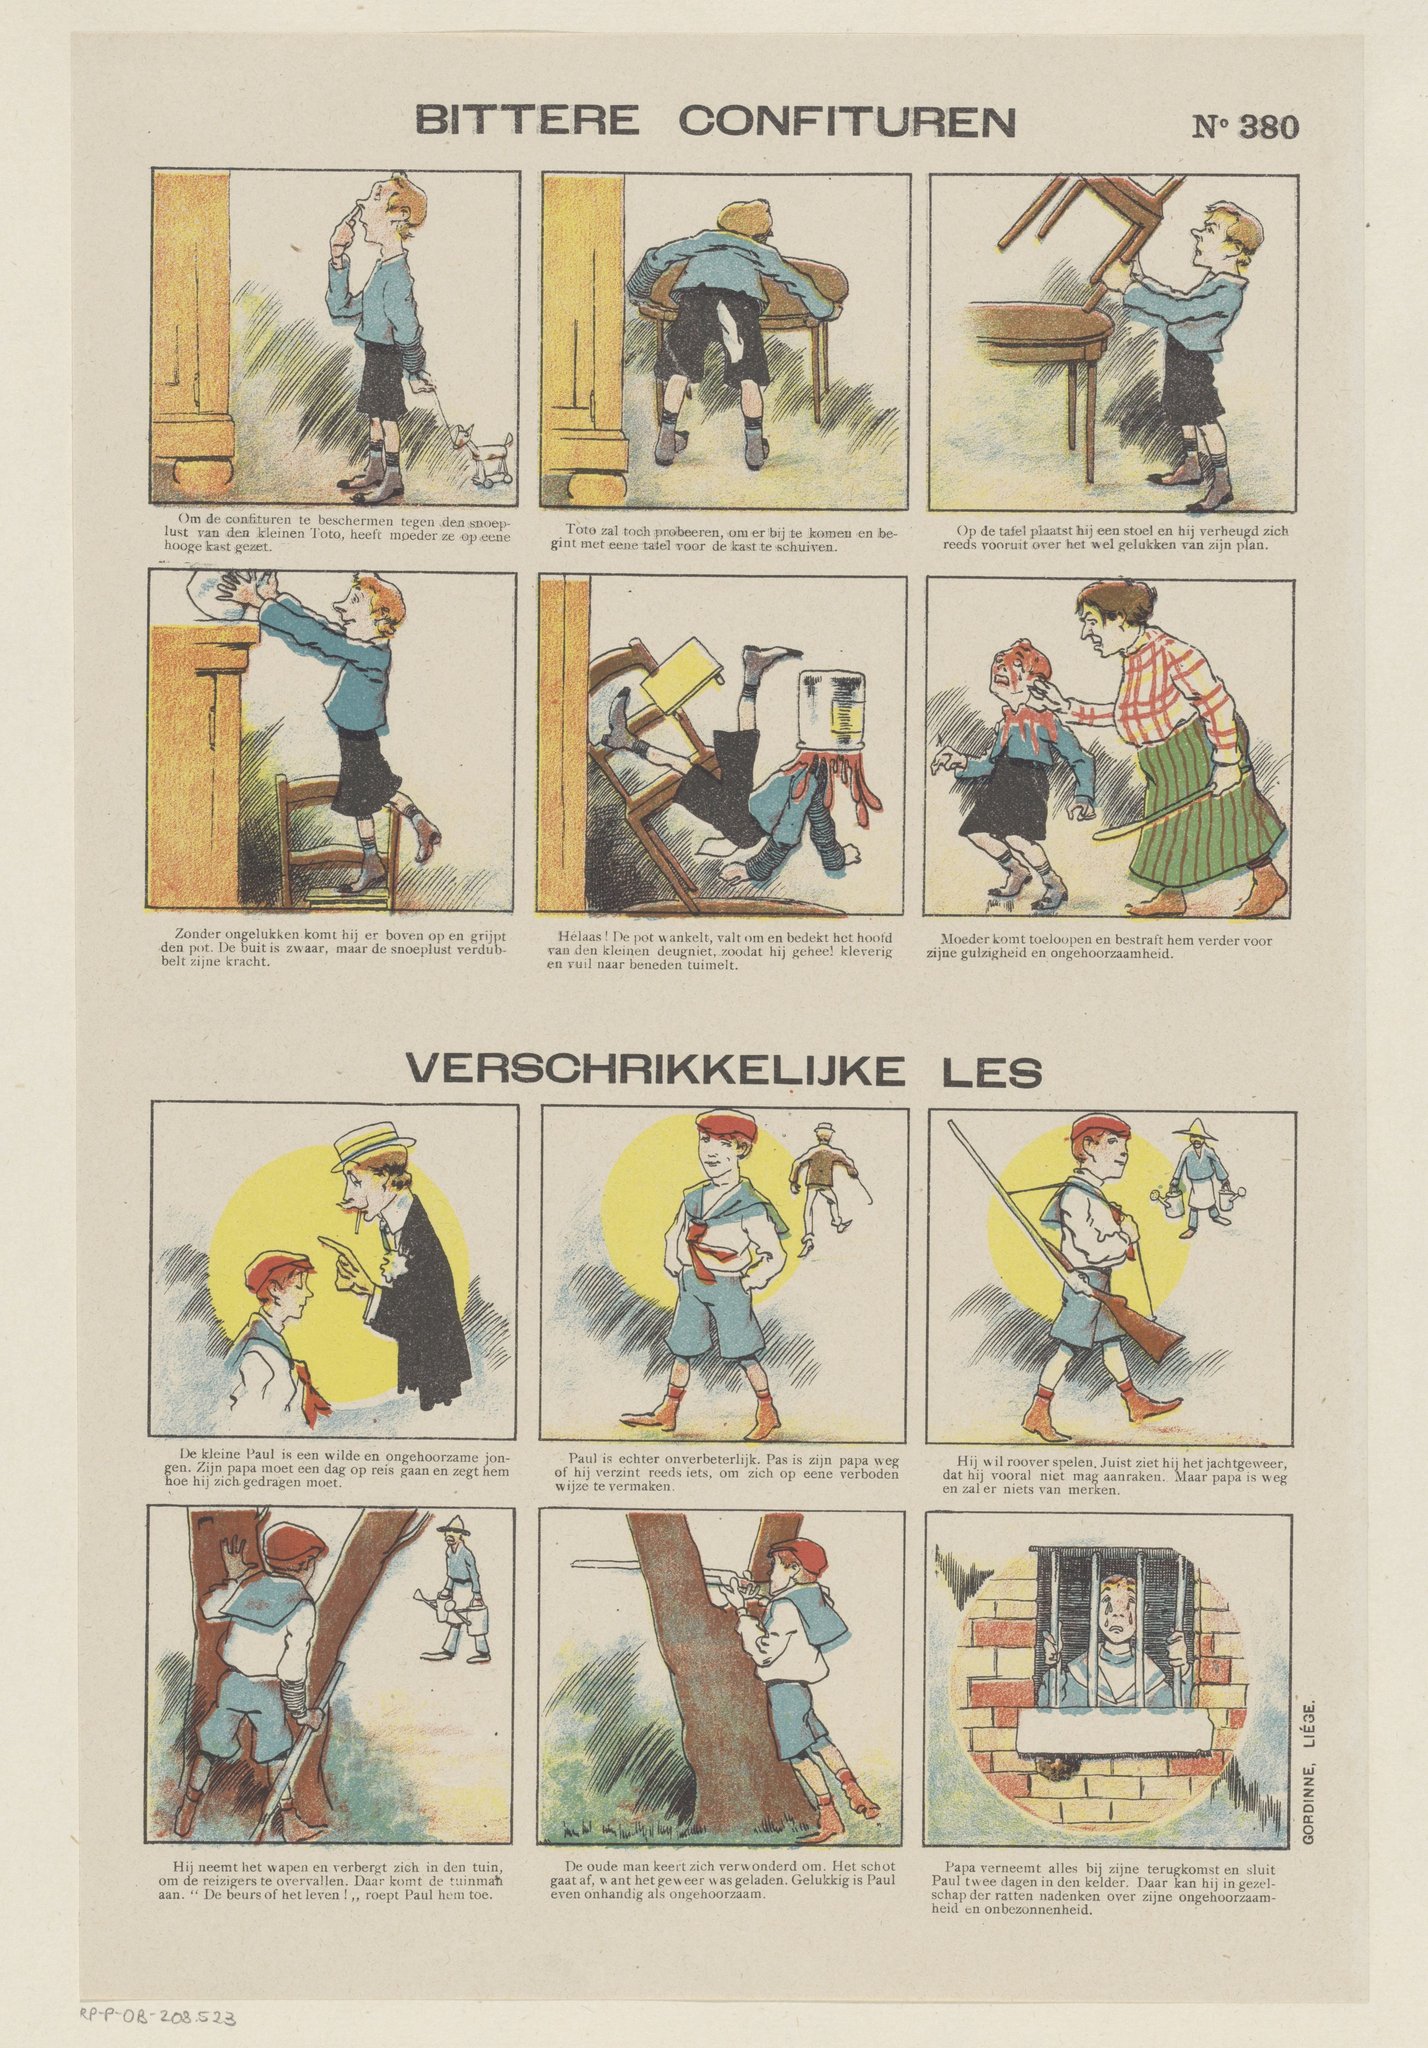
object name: print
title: Bittere confituren / Verschrikkelijke les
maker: Anonymous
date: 1894-1959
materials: paper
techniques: lithograph, letterpress printing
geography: liège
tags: correction of naughty children, bad behaviour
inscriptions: collector's mark: Lugt 2760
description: Blad met 12 voorstellingen. Boven zes voorstellingen over het jongetje Toto dat stiekem een pot vol zoetigheid van de kast probeert te pakken. Onder zes voorstellingen over de ongehoorzame jongen Paul die met het jachtgeweer van zijn vader speelt. Onder elke afbeelding een onderschrift. Genummerd rechtsboven: No 380.